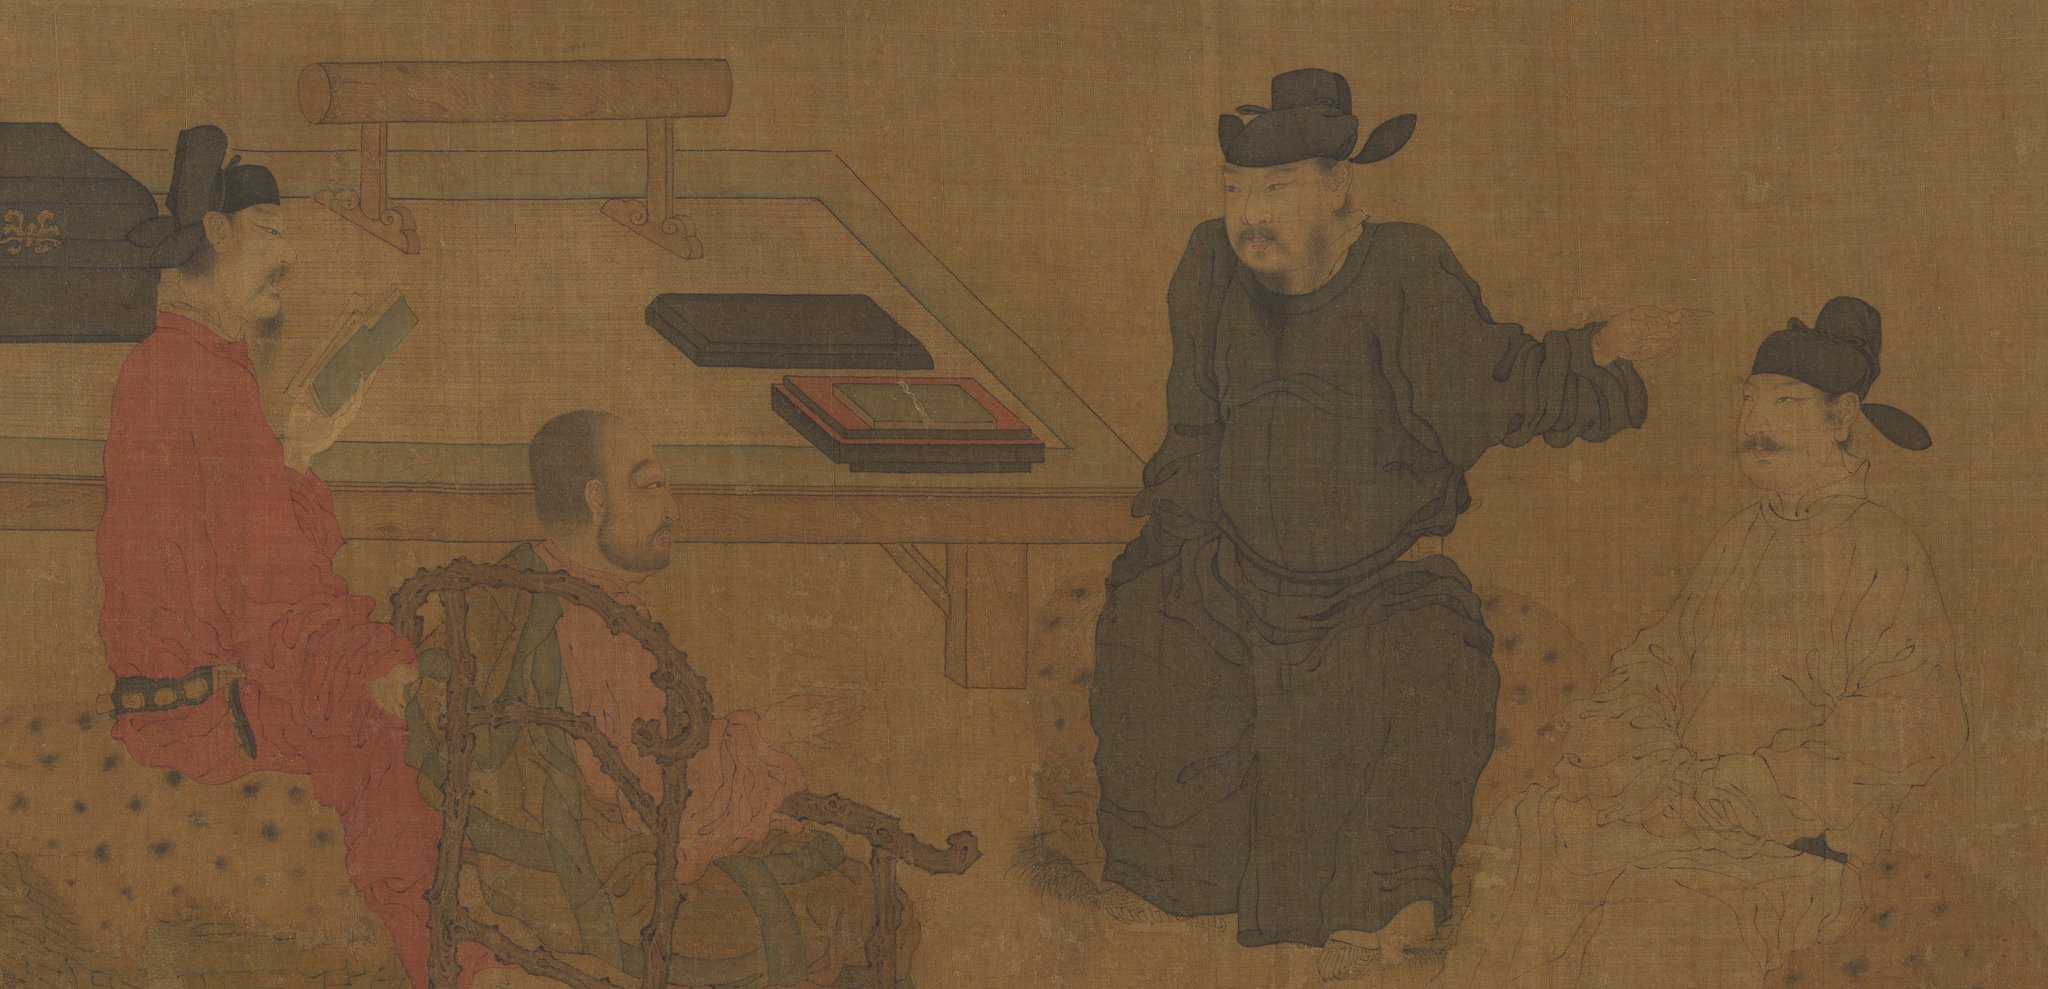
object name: handscroll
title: Scholars of the Liuli Hall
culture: chinese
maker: unidentified artist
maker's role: artist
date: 1267-1300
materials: ink, silk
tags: books,men,chairs,tables